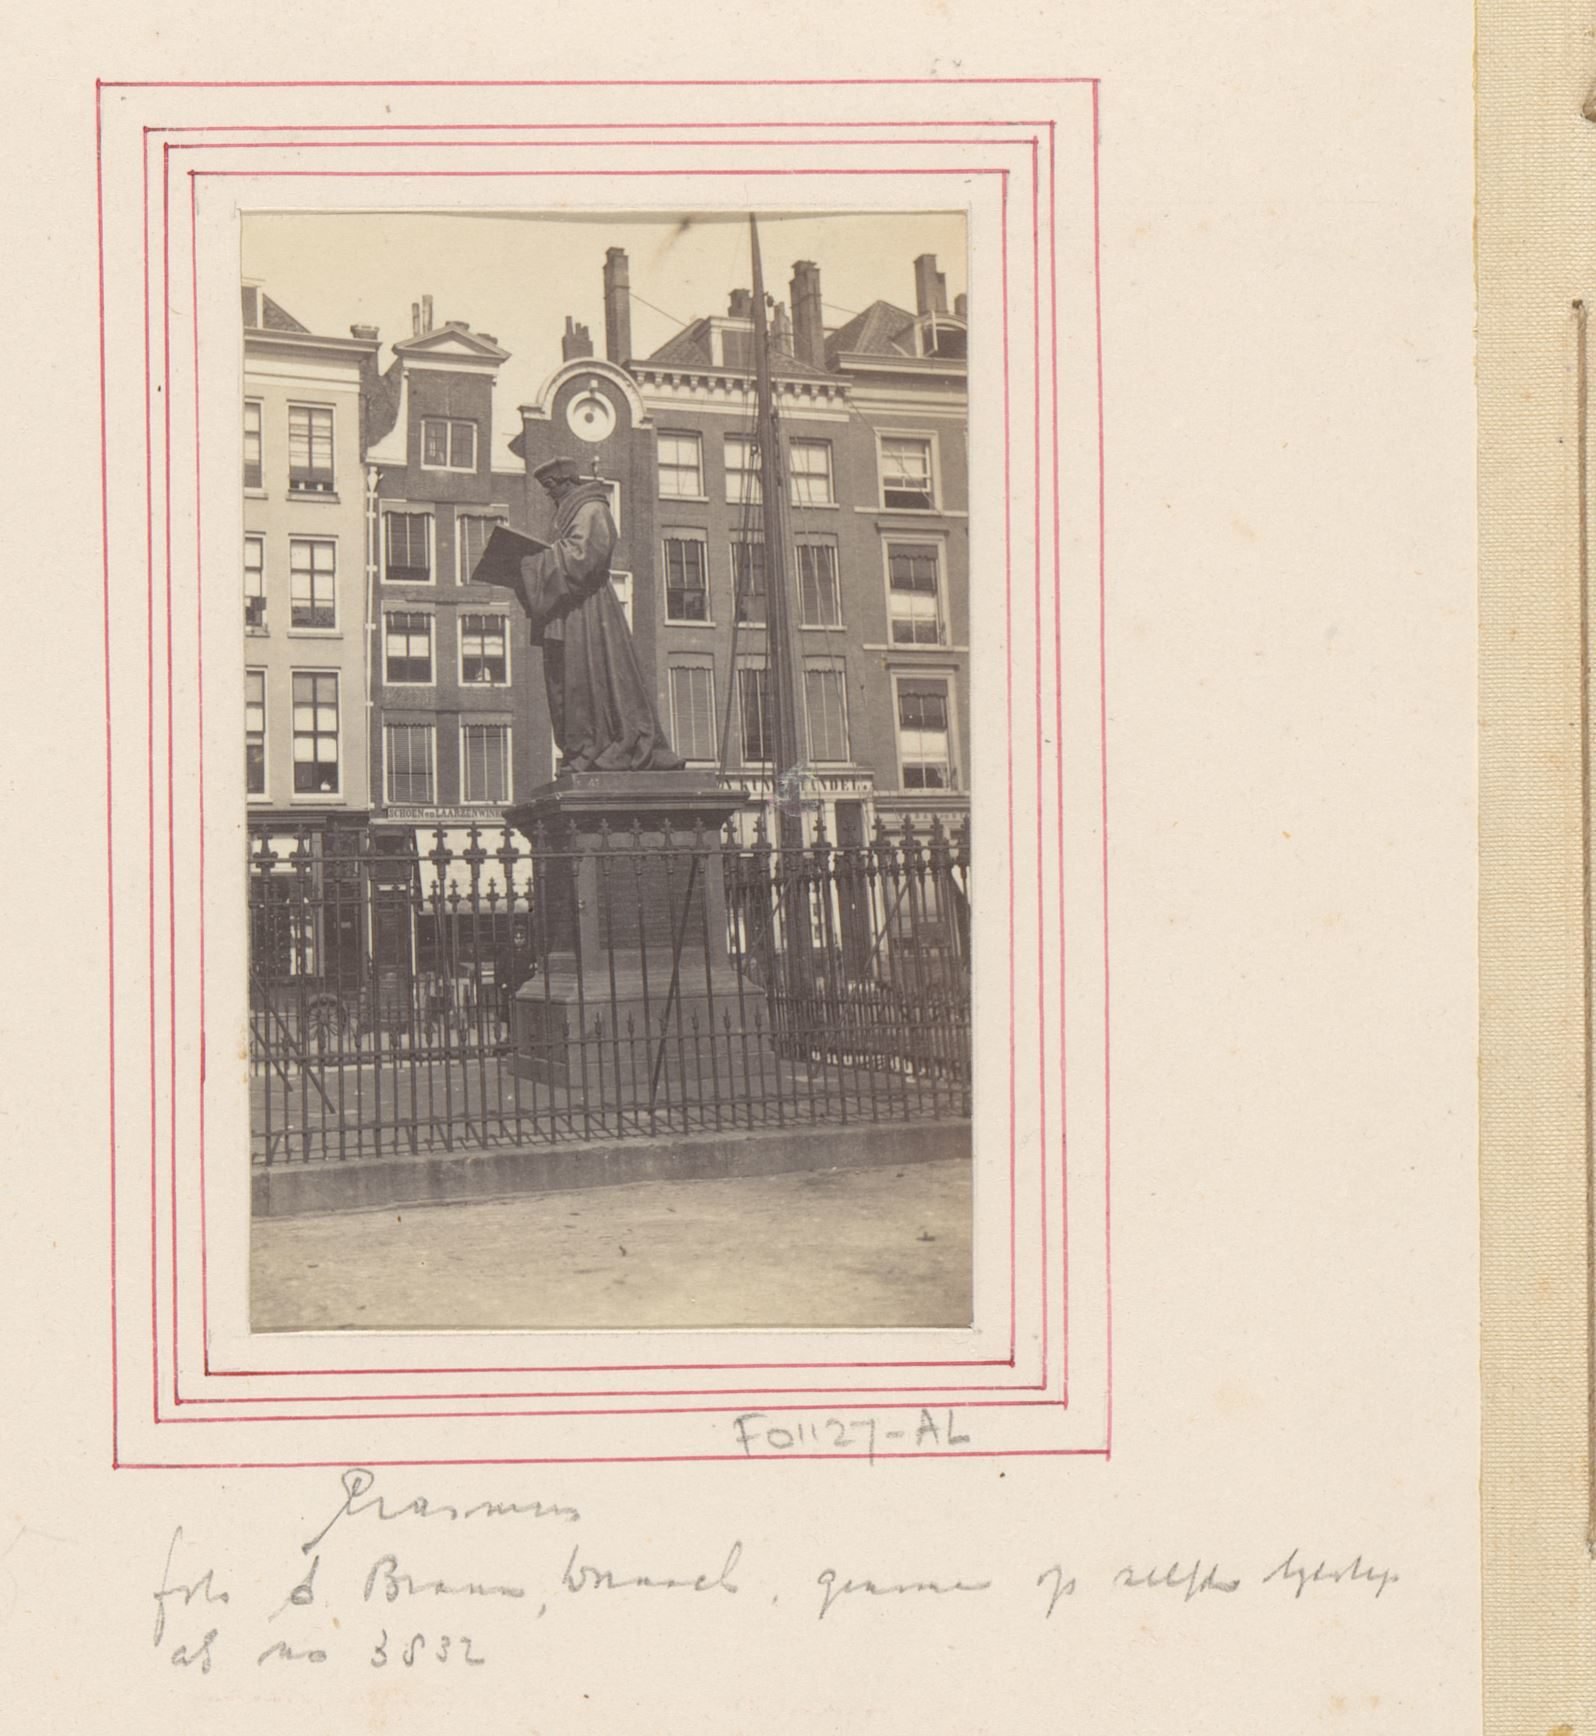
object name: photograph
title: Standbeeld van Erasmus op de Grote Markt in Rotterdam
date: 1870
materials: photographic support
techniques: albumen print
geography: grotemarkt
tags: desiderius erasmus, monument, statue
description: Onderdeel van Album met foto's en litho's van bezienswaardigheden in Noord- en Zuid-Hollandse steden, schilderijen en klederdrachten.